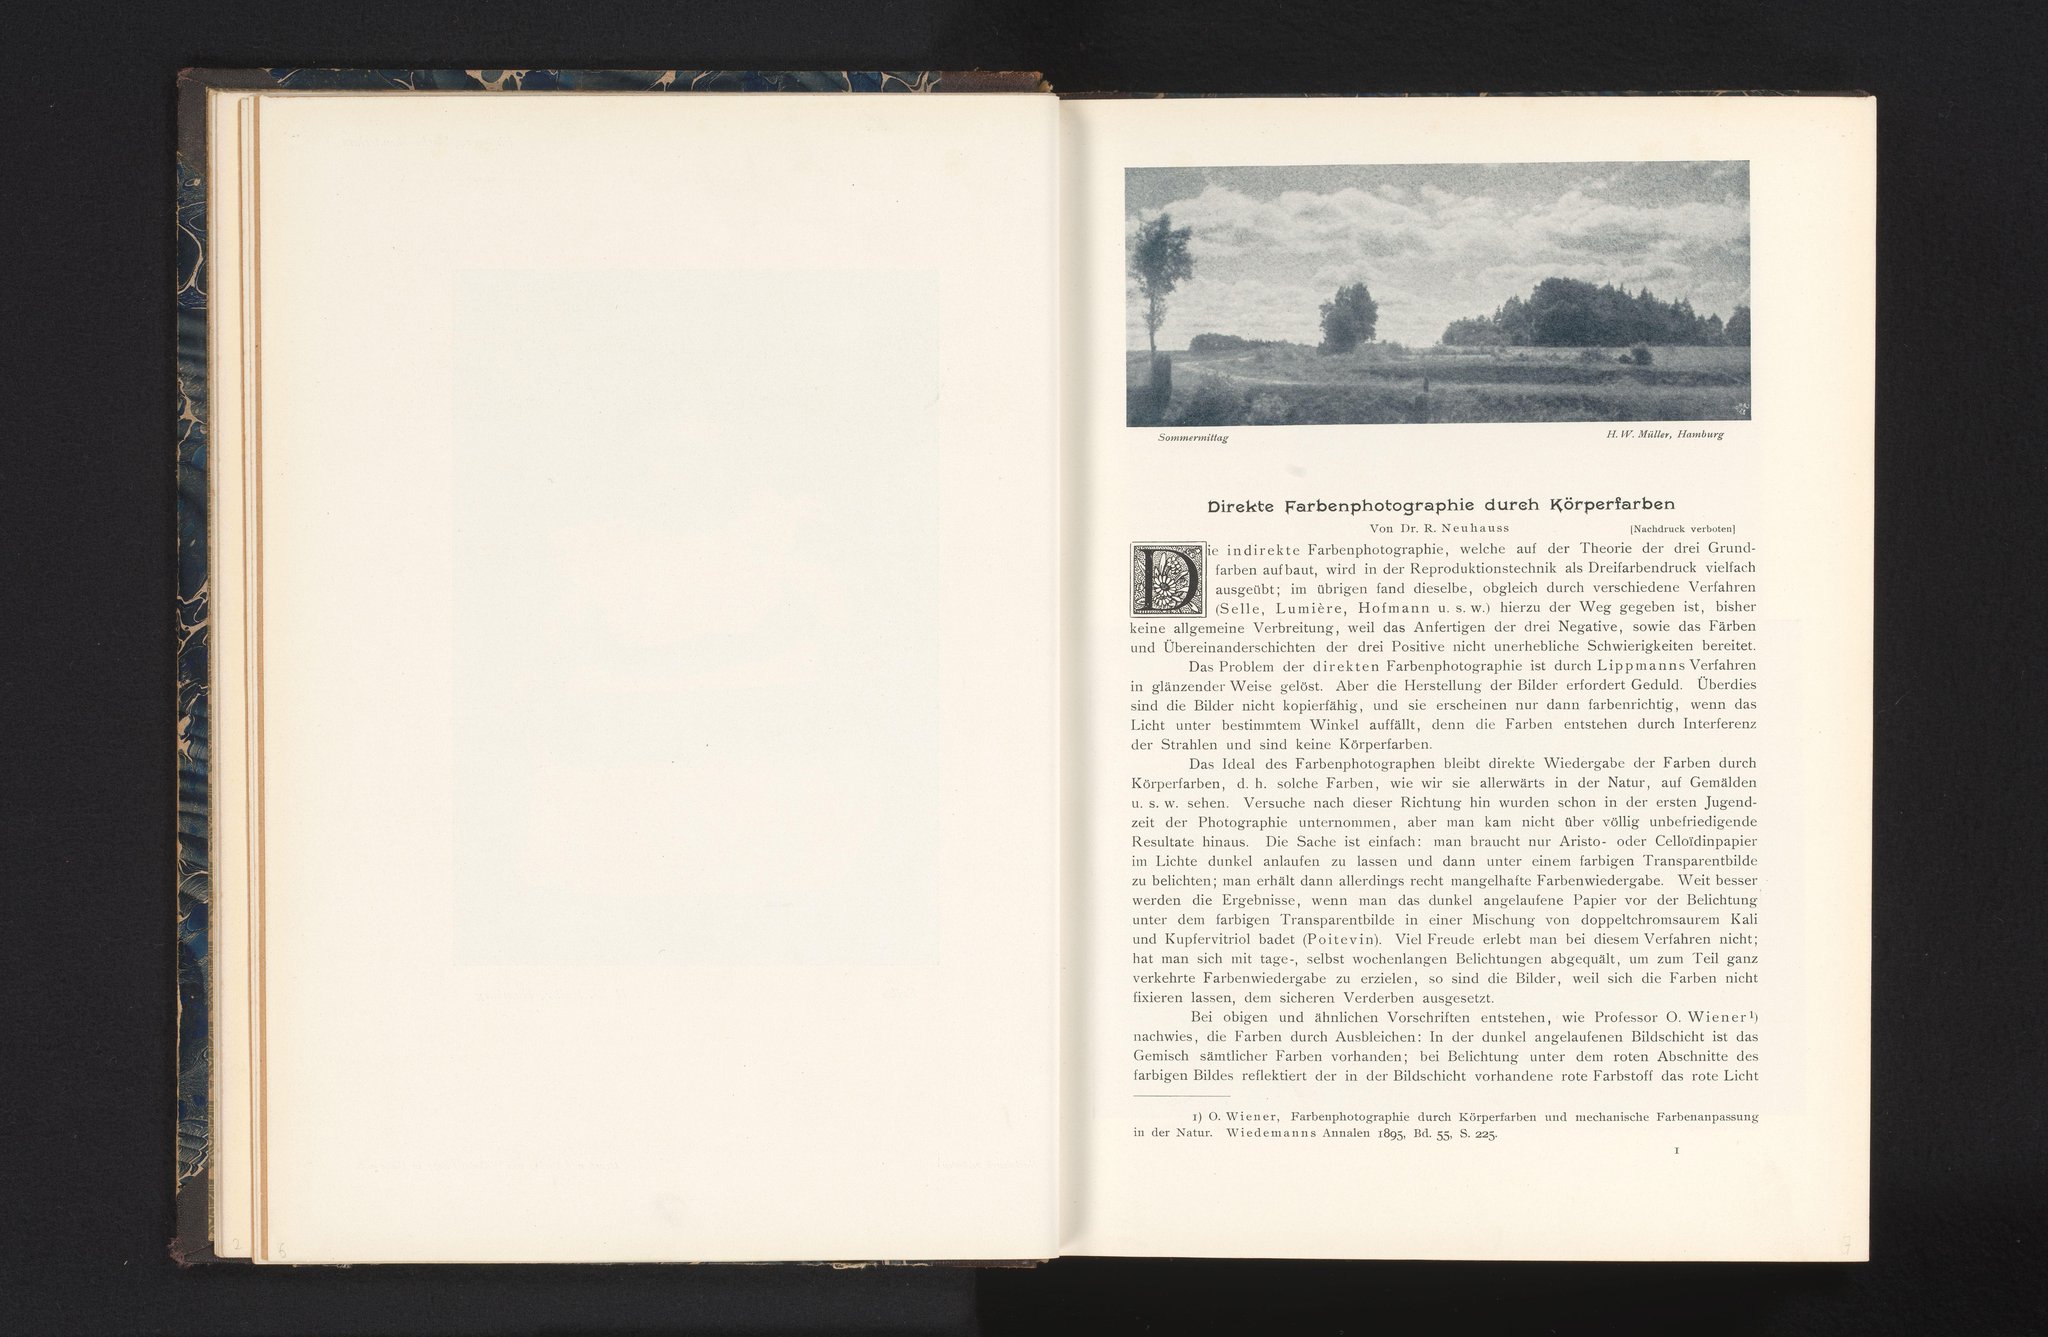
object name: photomechanical print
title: Gezicht op een landschap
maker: h.w. müller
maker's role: fotograaf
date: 1897-1902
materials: paper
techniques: autotype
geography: berlin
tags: landscapes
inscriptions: monogram: ‘MR&C’